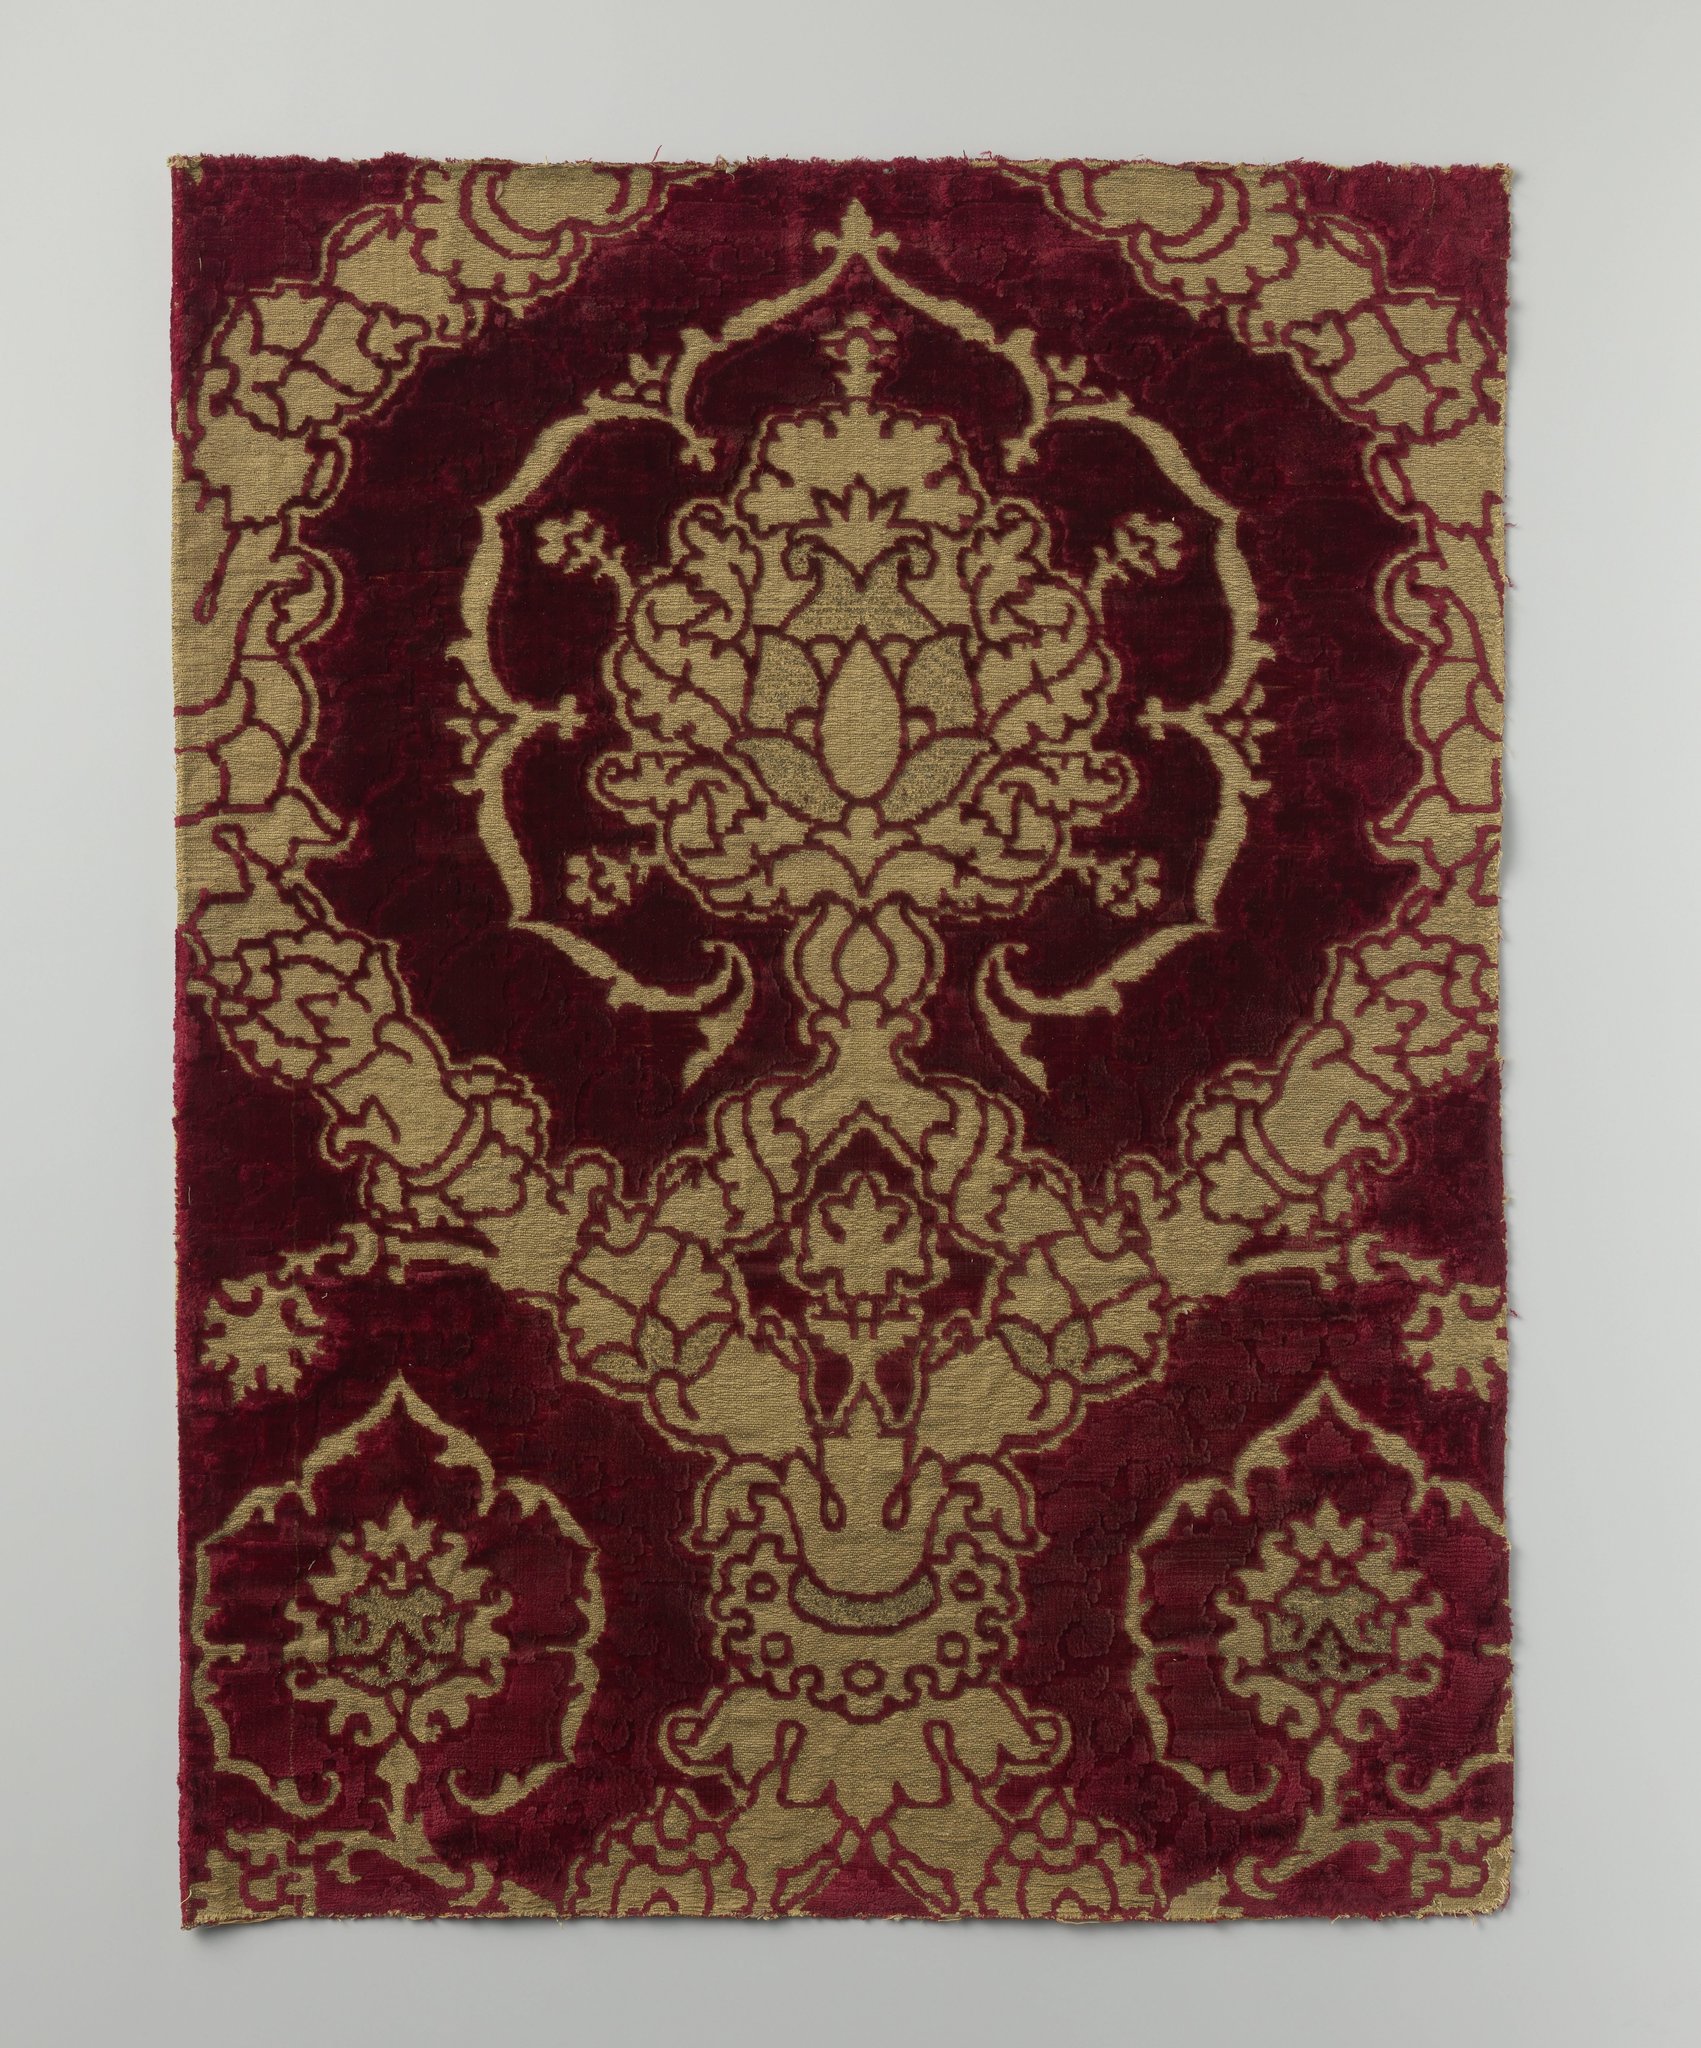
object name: brokaatfluweel, fluweelbrokaat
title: Fragment zijden fluweelbrokaat op gouden grond met granaatappelpatroon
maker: Anonymous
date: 1450-1525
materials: linen, metal thread, silk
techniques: bouclé, relief velvet, satin binding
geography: italy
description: Fragment zijden fluweel op gouden grond. Dessin: op een door een gouden inslag georneerd fond verheft zich in wijnrood pili-on-pile fluweel en op sommige plaatsen gekruld goud, een patroon, bestaande uit een granaatappel, ombladerd in een groot gelobd blad, omgeven door een zware loofkrans, afwisselend met twee kleinere op dezelfde wijze versierde bladeren. Opmerking: vergelijk met bk-nm-12364.